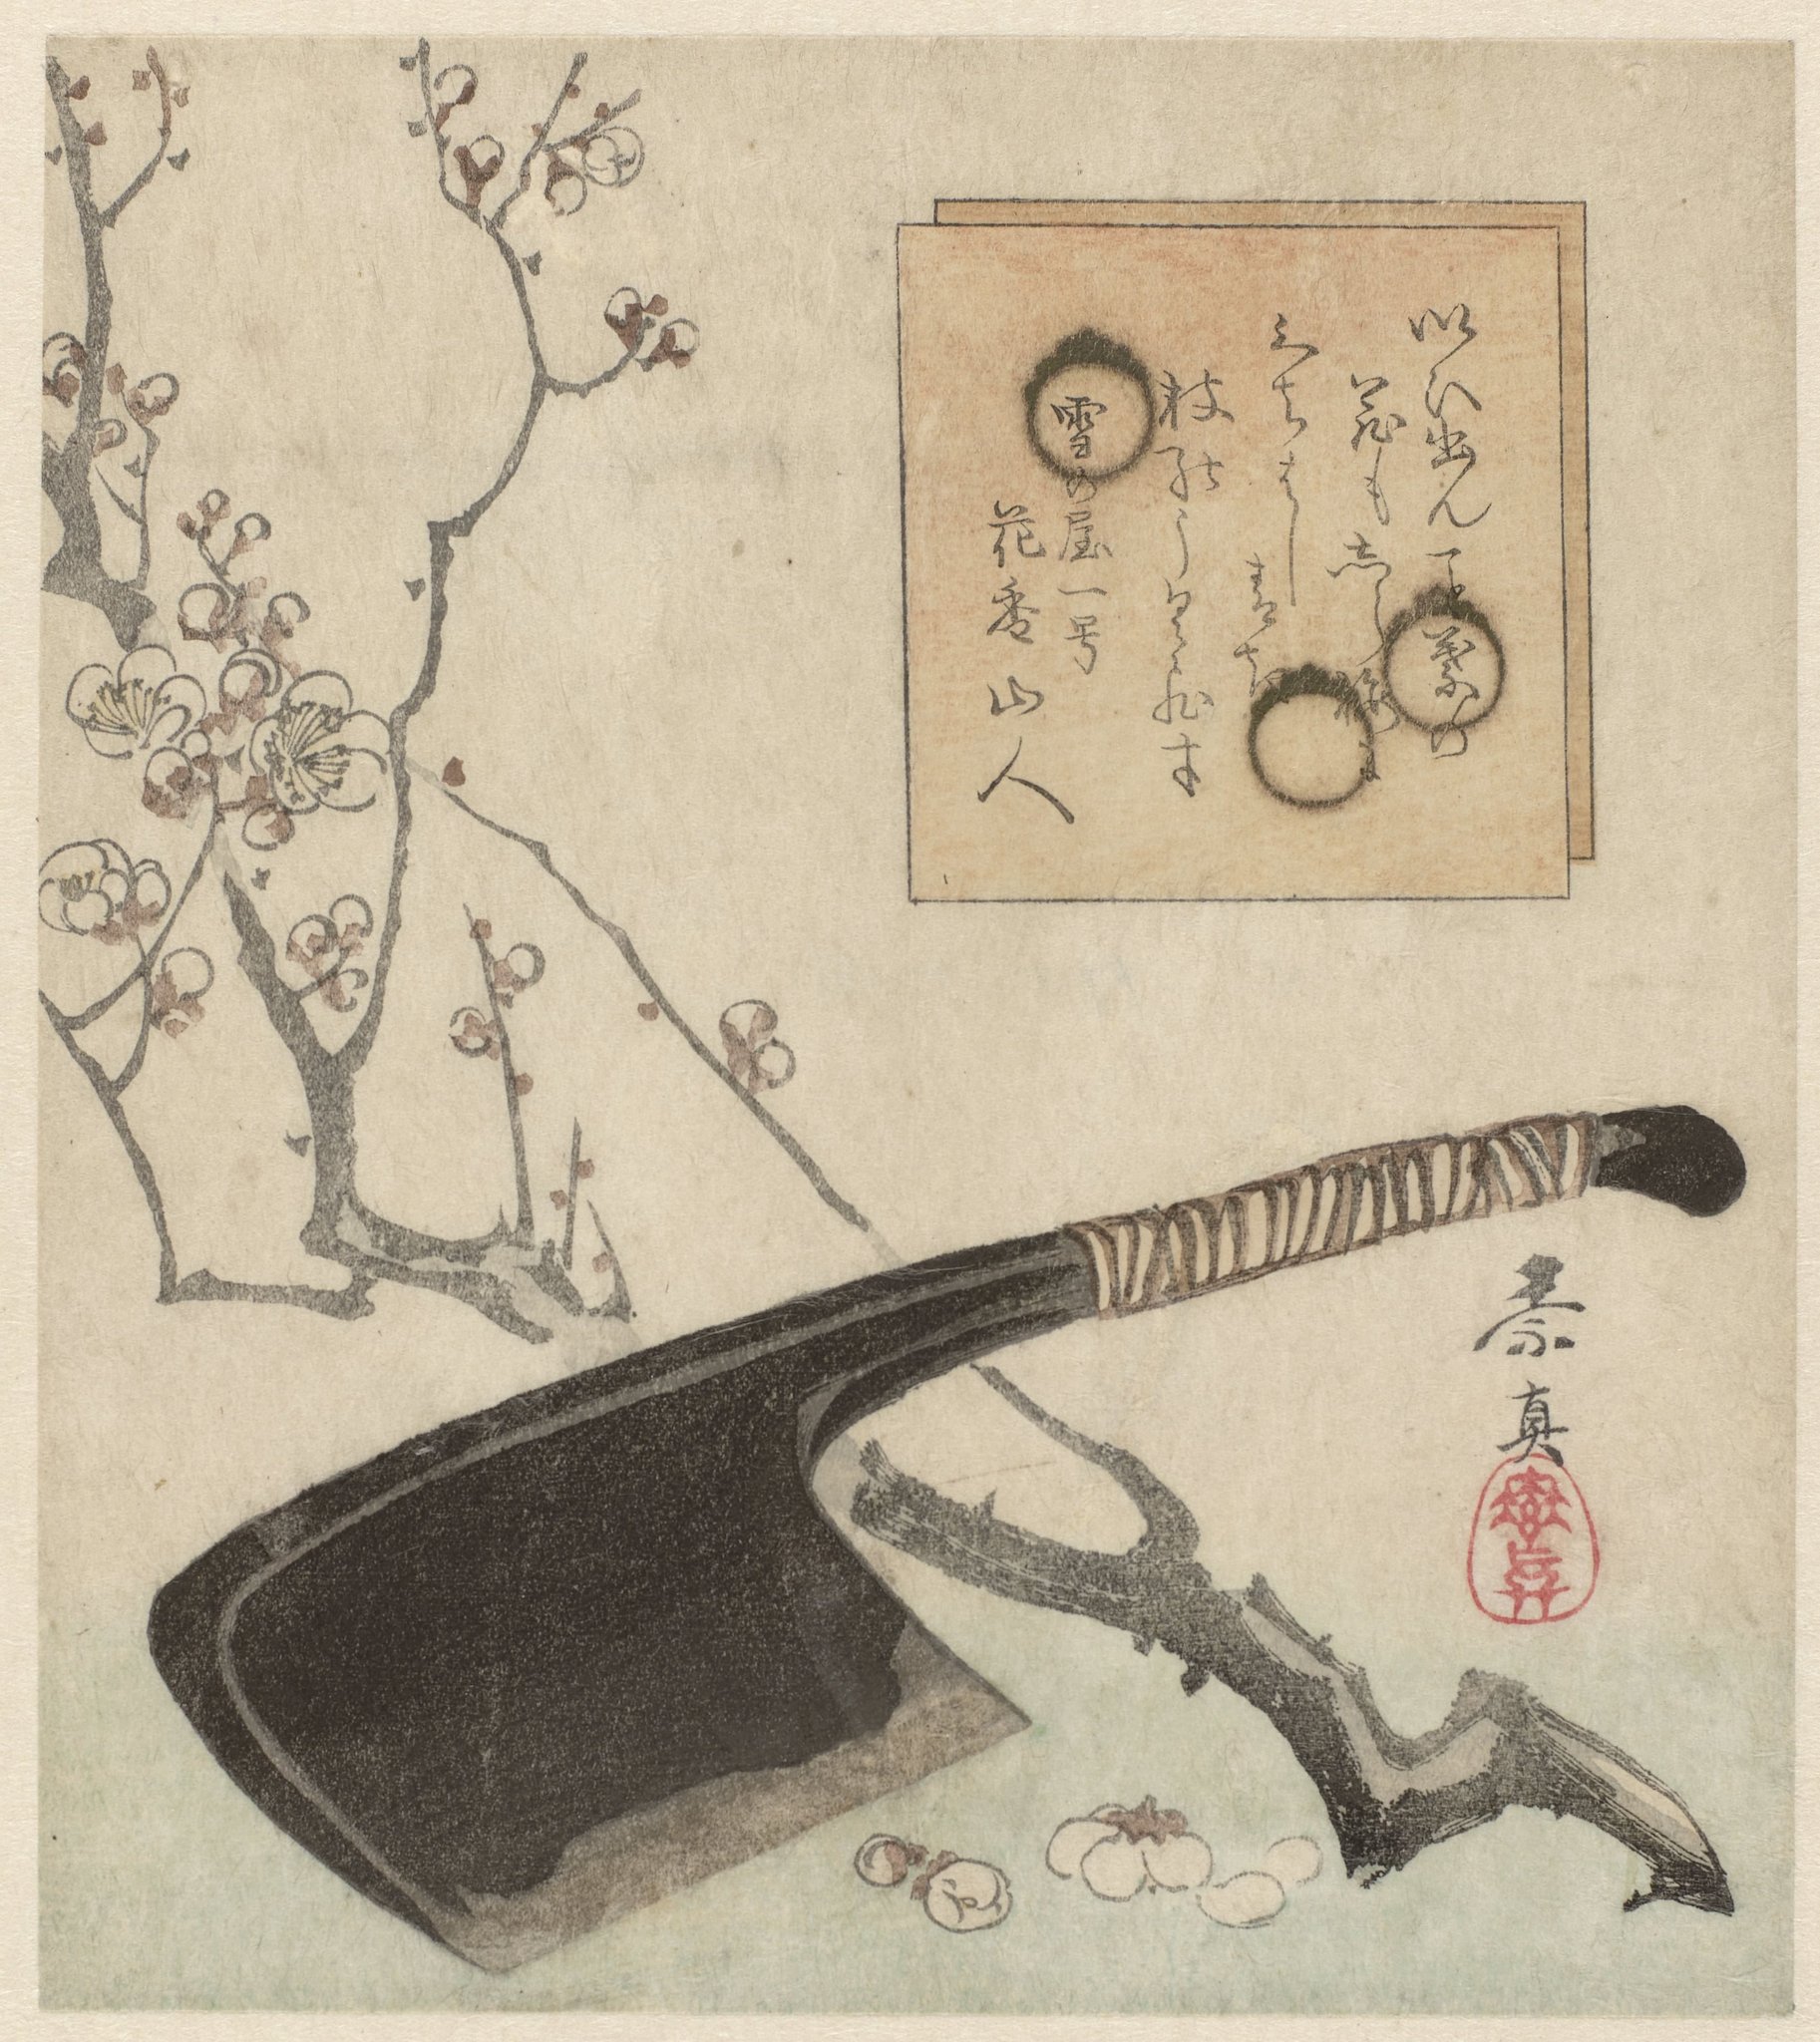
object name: print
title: Stilleven met hakmes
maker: Anonymous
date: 1835-1845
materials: paper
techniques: woodcut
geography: japan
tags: flowers (+ variant), tools, aids, implements ~ crafts and industries: axe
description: Een surimono is een luxe uitgevoerde prent waarop beeld met één of meerdere gedichten gecombineerd is. Bij het drukken van een surimono werd vaak gebruik gemaakt van dikker papier, blinddruk en metaal pigmenten, zoals koper- en zilverpoeder. De prenten werden vaak in opdracht van dichters gemaakt en als exclusief geschenk aan vrienden en relaties gegeven.